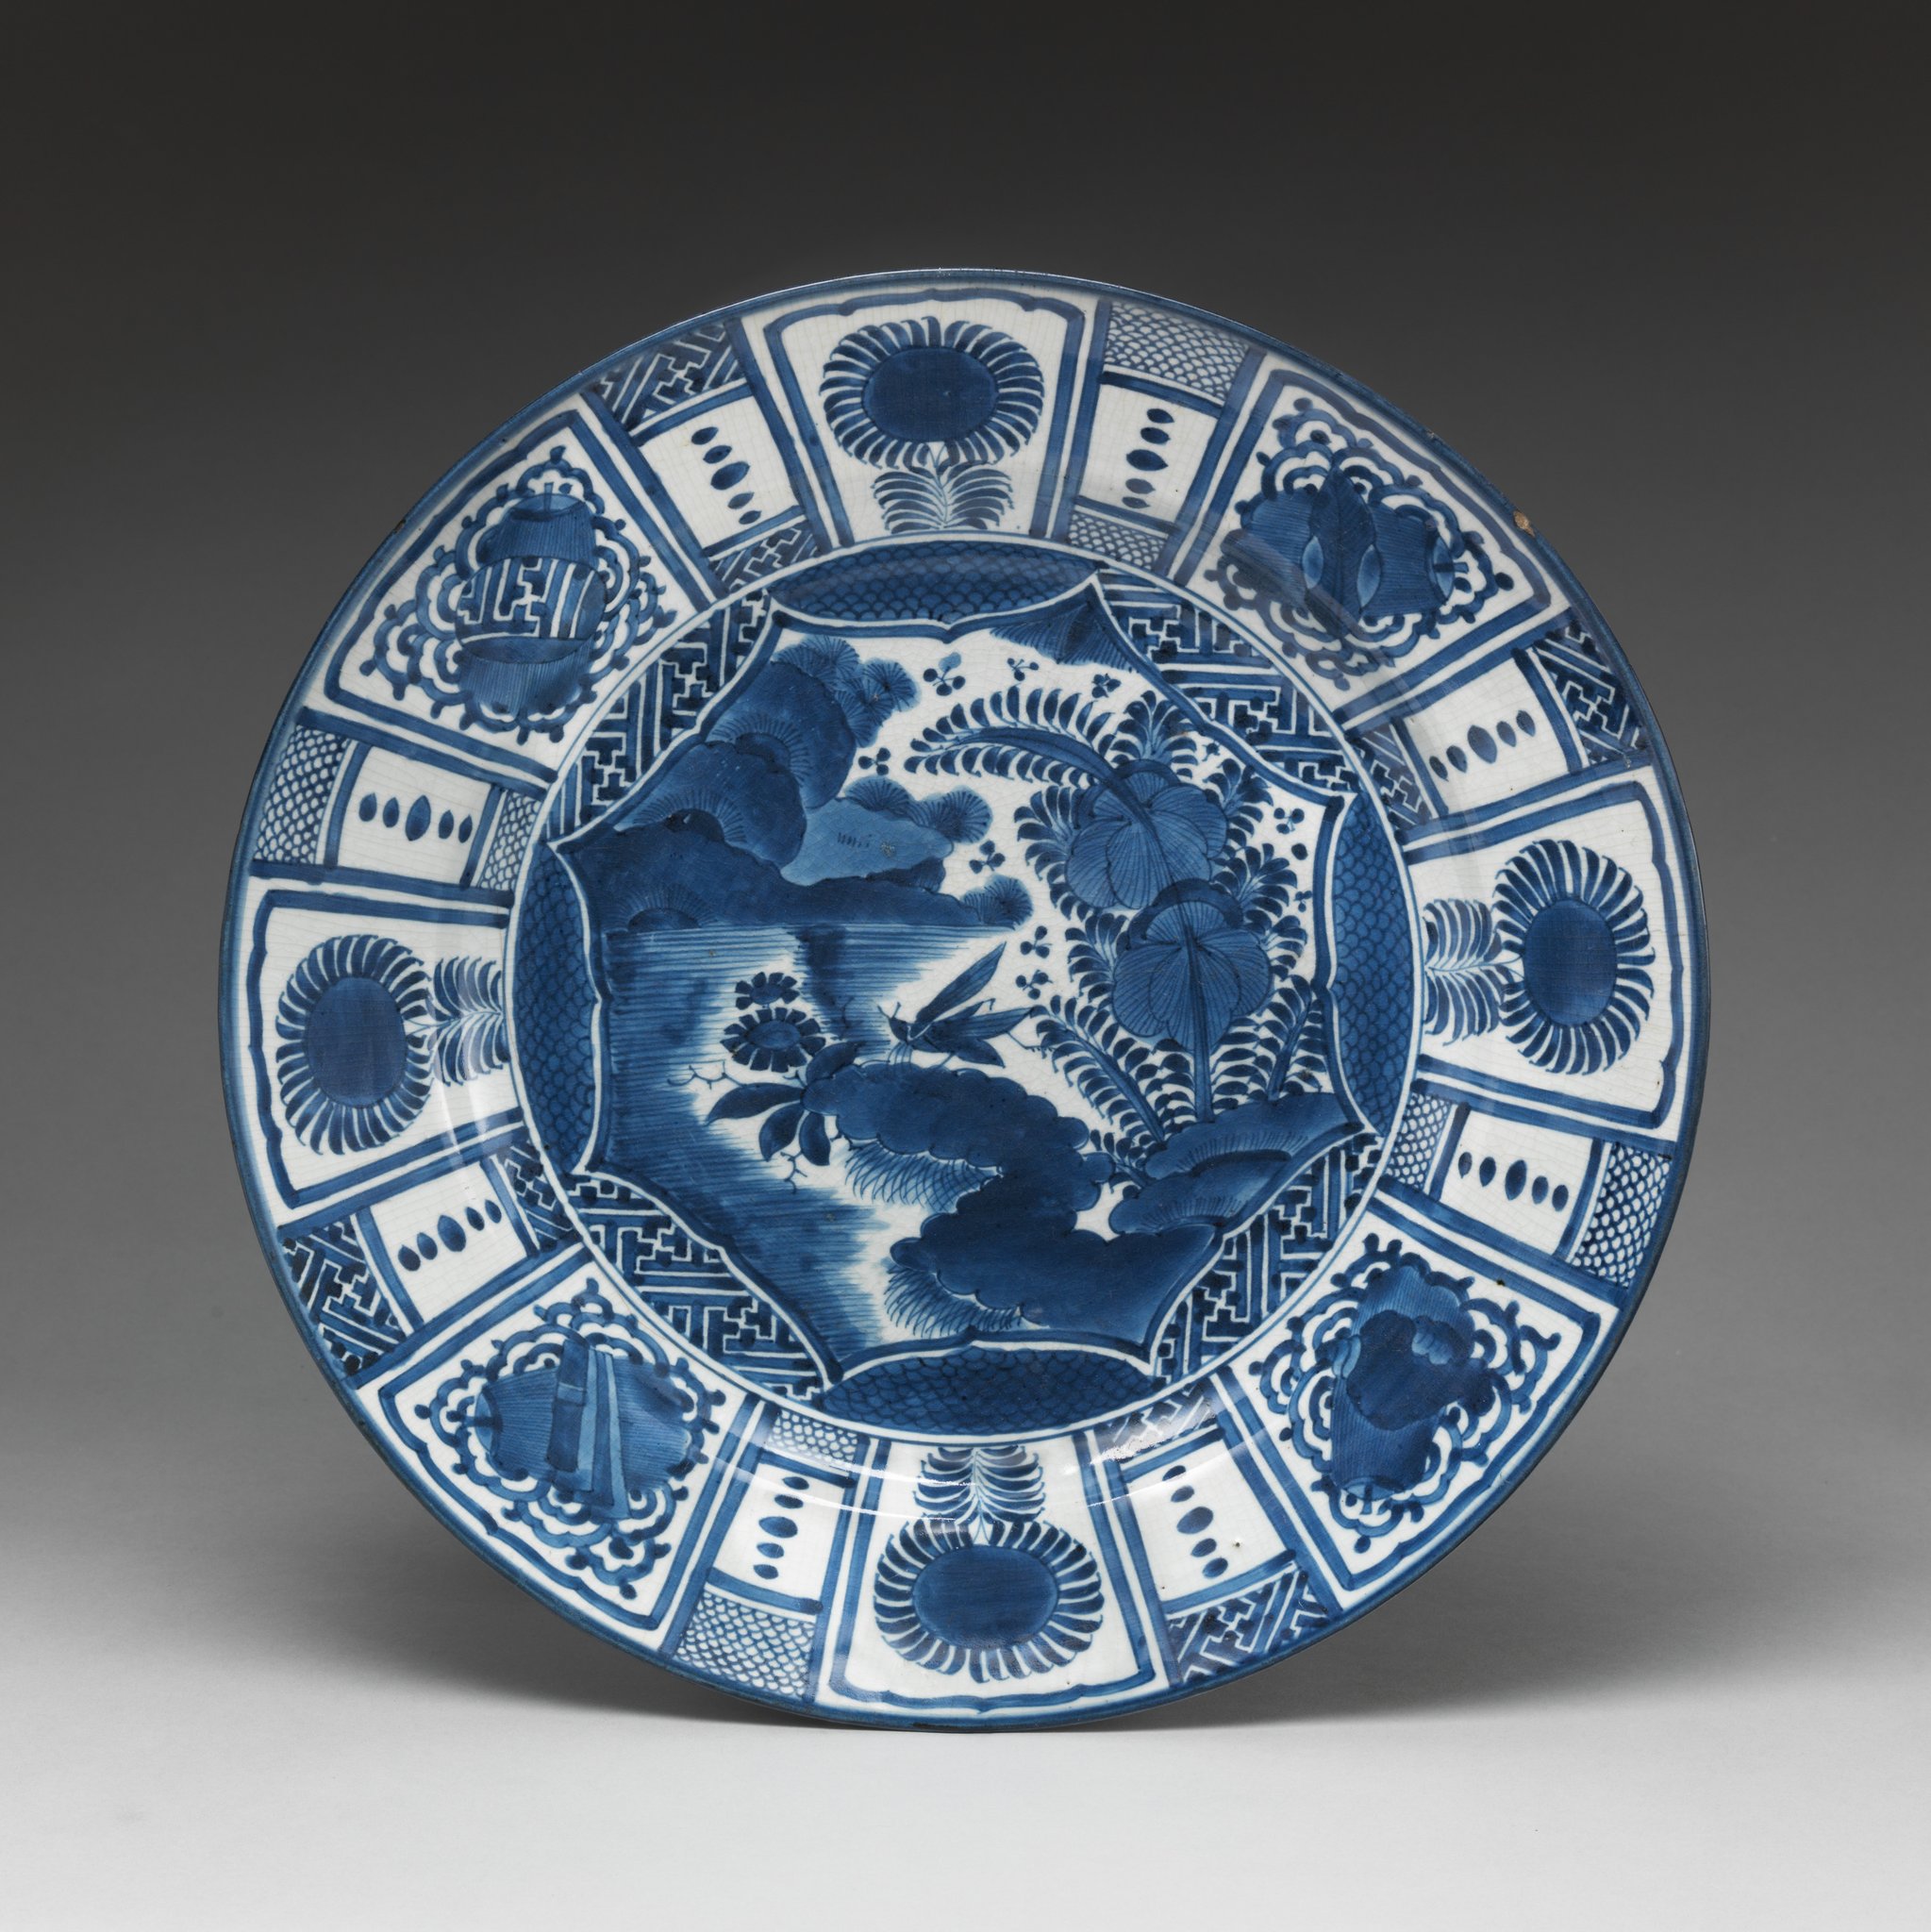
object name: dish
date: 1670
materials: hard paste porcelain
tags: flowers